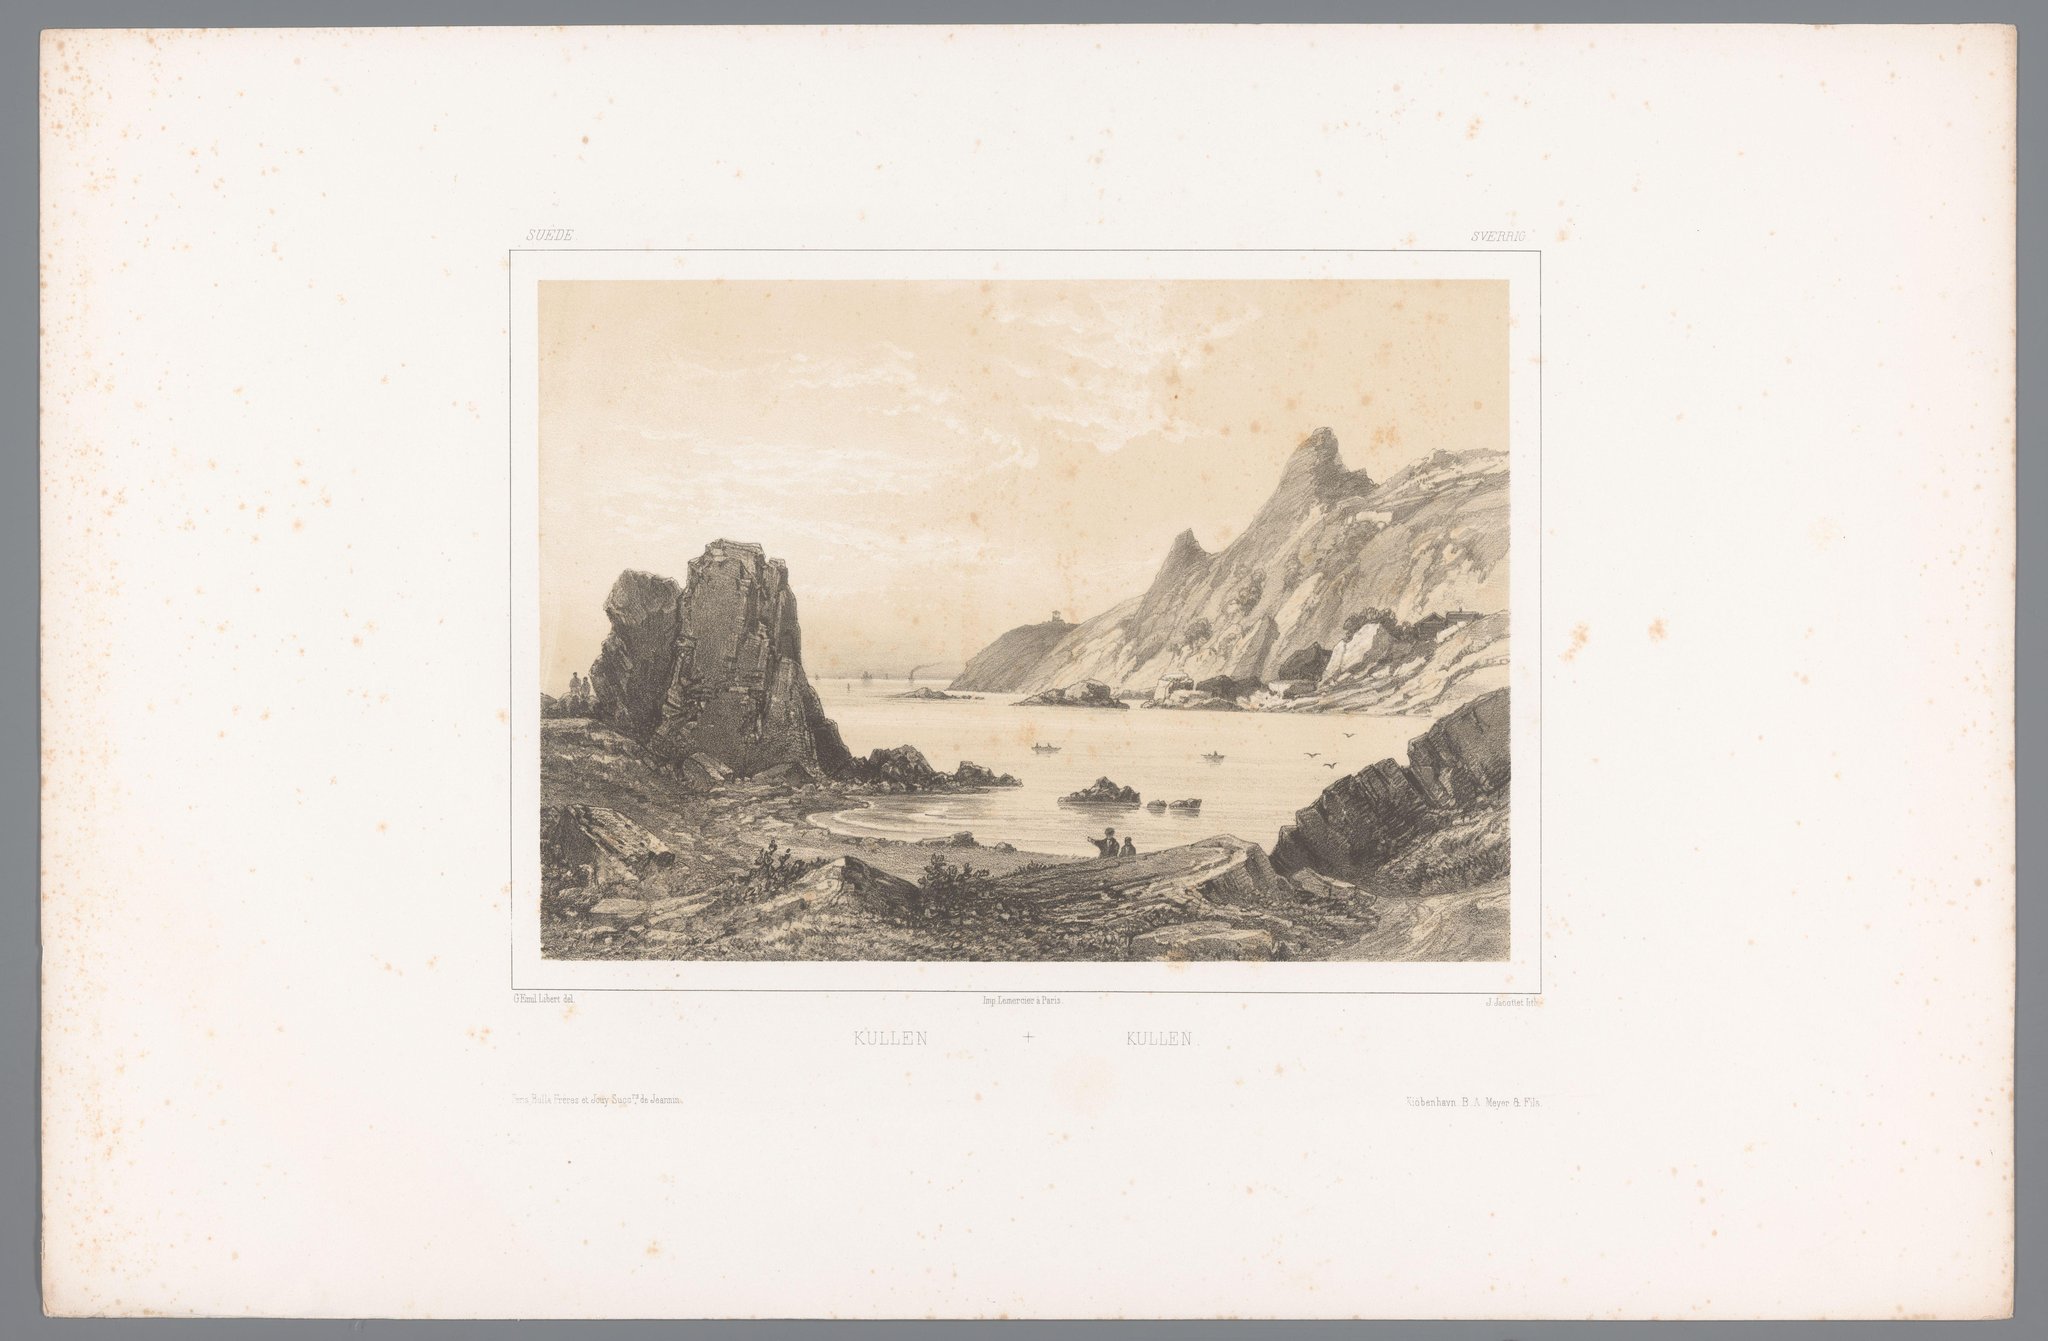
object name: print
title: Vues du Nord. Suède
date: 1851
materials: paper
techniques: tone lithography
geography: paris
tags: gulf, bay (+ landscape with figures, staffage), peninsula (+ landscape with figures, staffage), rocks (+ landscape with figures, staffage)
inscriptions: collector's mark: Lugt 2228a